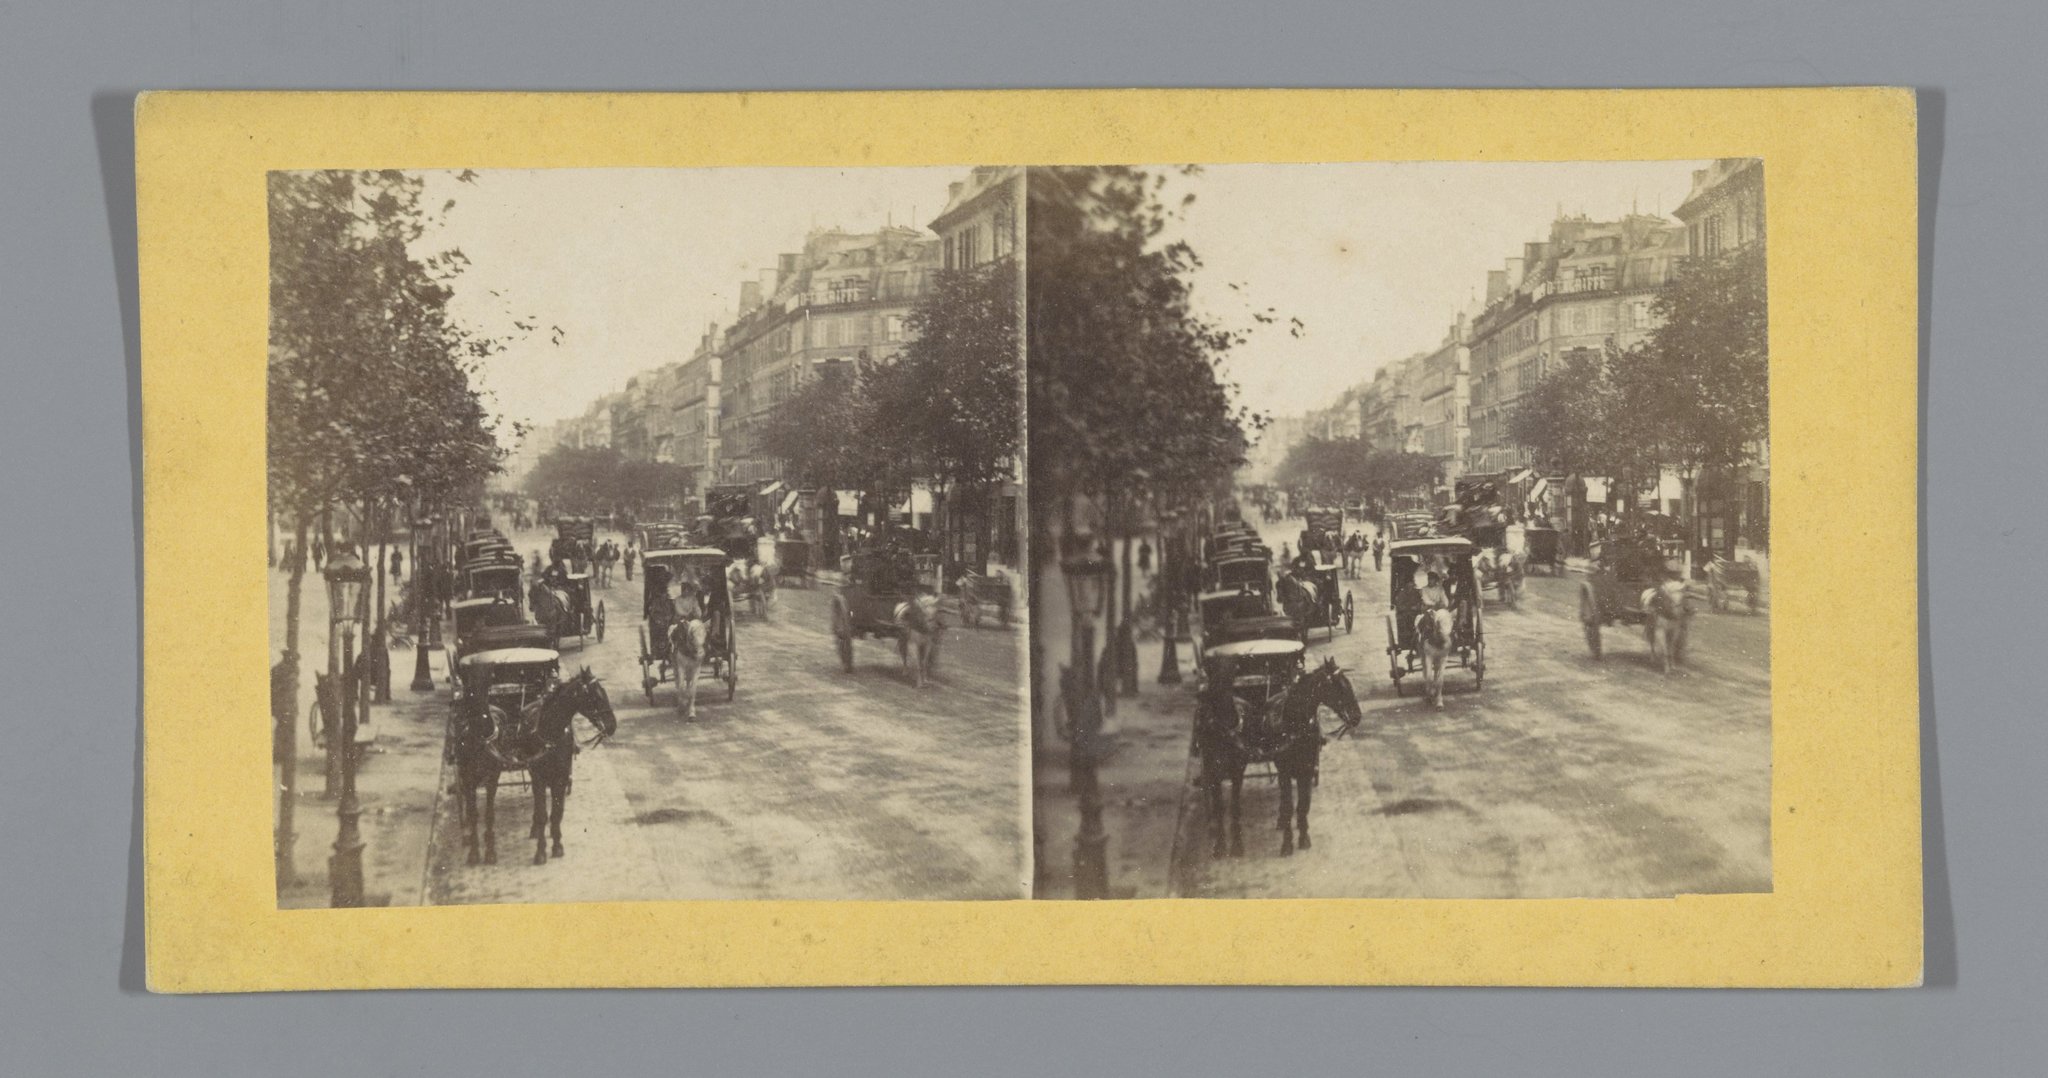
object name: stereograph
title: Gezicht op een boulevard te Parijs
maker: Anonymous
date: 1850-1875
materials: cardboard, photographic support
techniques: albumen print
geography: paris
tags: four-wheeled, animal-drawn vehicle, e.g.: cab, carriage, coach, avenue, boulevard, promenade, esplanade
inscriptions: number: ‘N. 12’